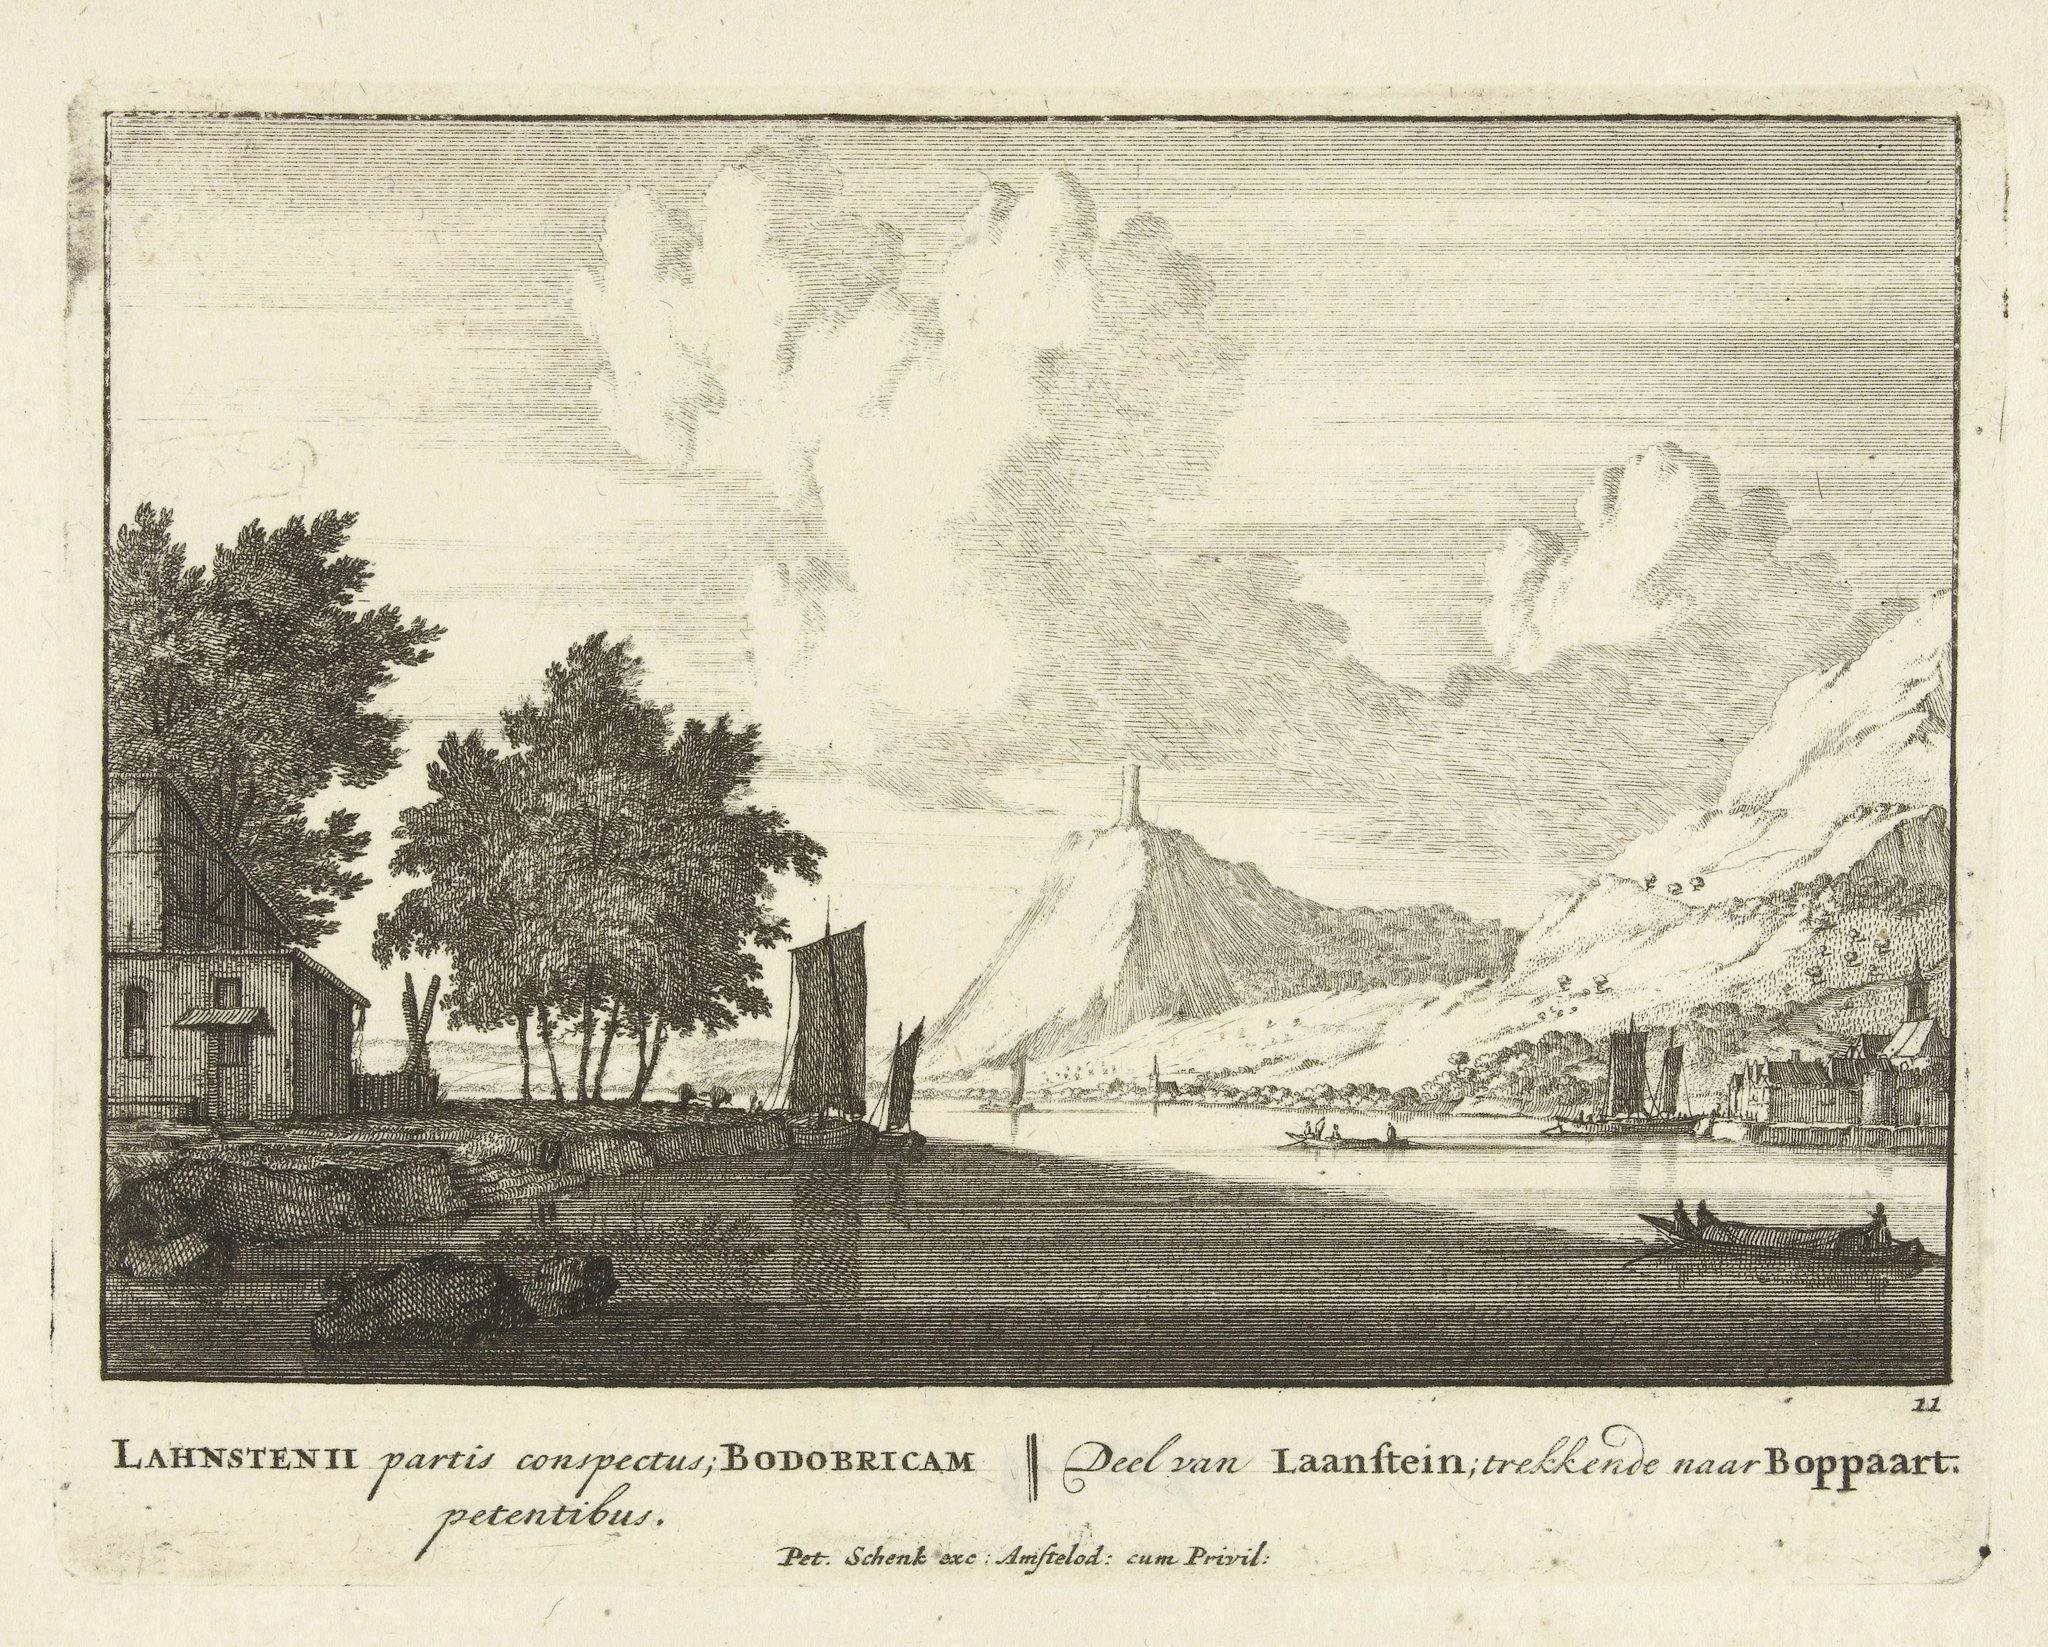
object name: print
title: Vermakelijke gezigten aan den Rhijnstroom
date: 1694-1697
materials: paper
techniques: etching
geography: amsterdam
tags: river, landscape with tower or castle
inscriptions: collector's mark: Lugt 2228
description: Prent uit een serie van 71 prenten met Rijnlandschappen, gezichten op vorstelijke paleizen en stadsgezichten uit Den Haag en Amsterdam.